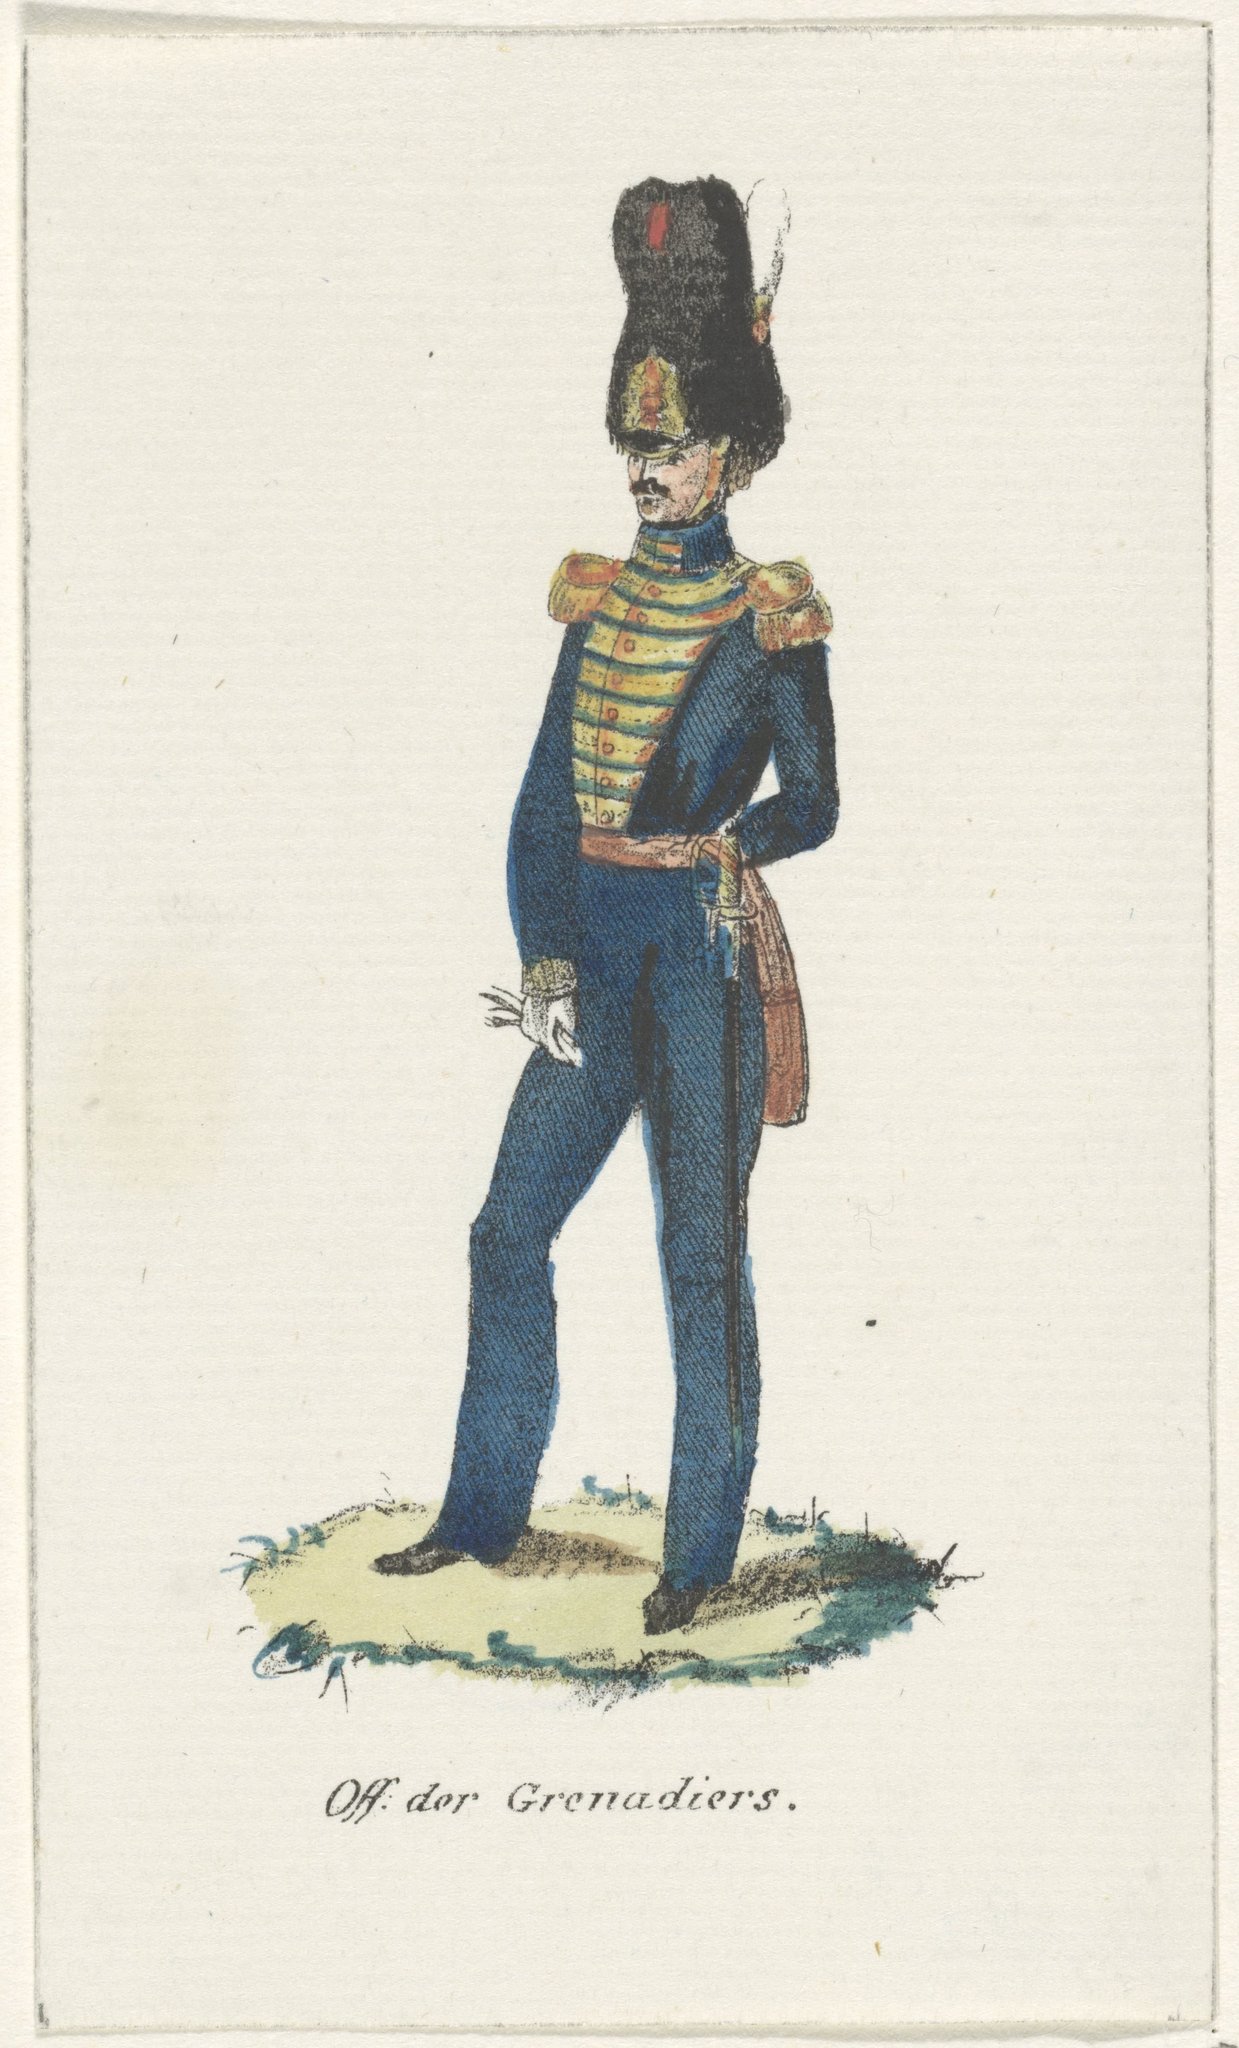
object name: print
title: 21 platen van Nederlandse uniformen ca. 1830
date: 1830-1835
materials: paper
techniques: hand coloring, lithograph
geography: netherlands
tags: (military) uniforms, clothes, costume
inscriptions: collector's mark: Lugt 2228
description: Verkleinde kopieën naar de prenten van Houtman e.a. in FMH 6481. Muller beschrijft een onversneden compleet blad in de collectie Van Gijn waarop de namen van de prentmaker en de uitgever vermeld staan.